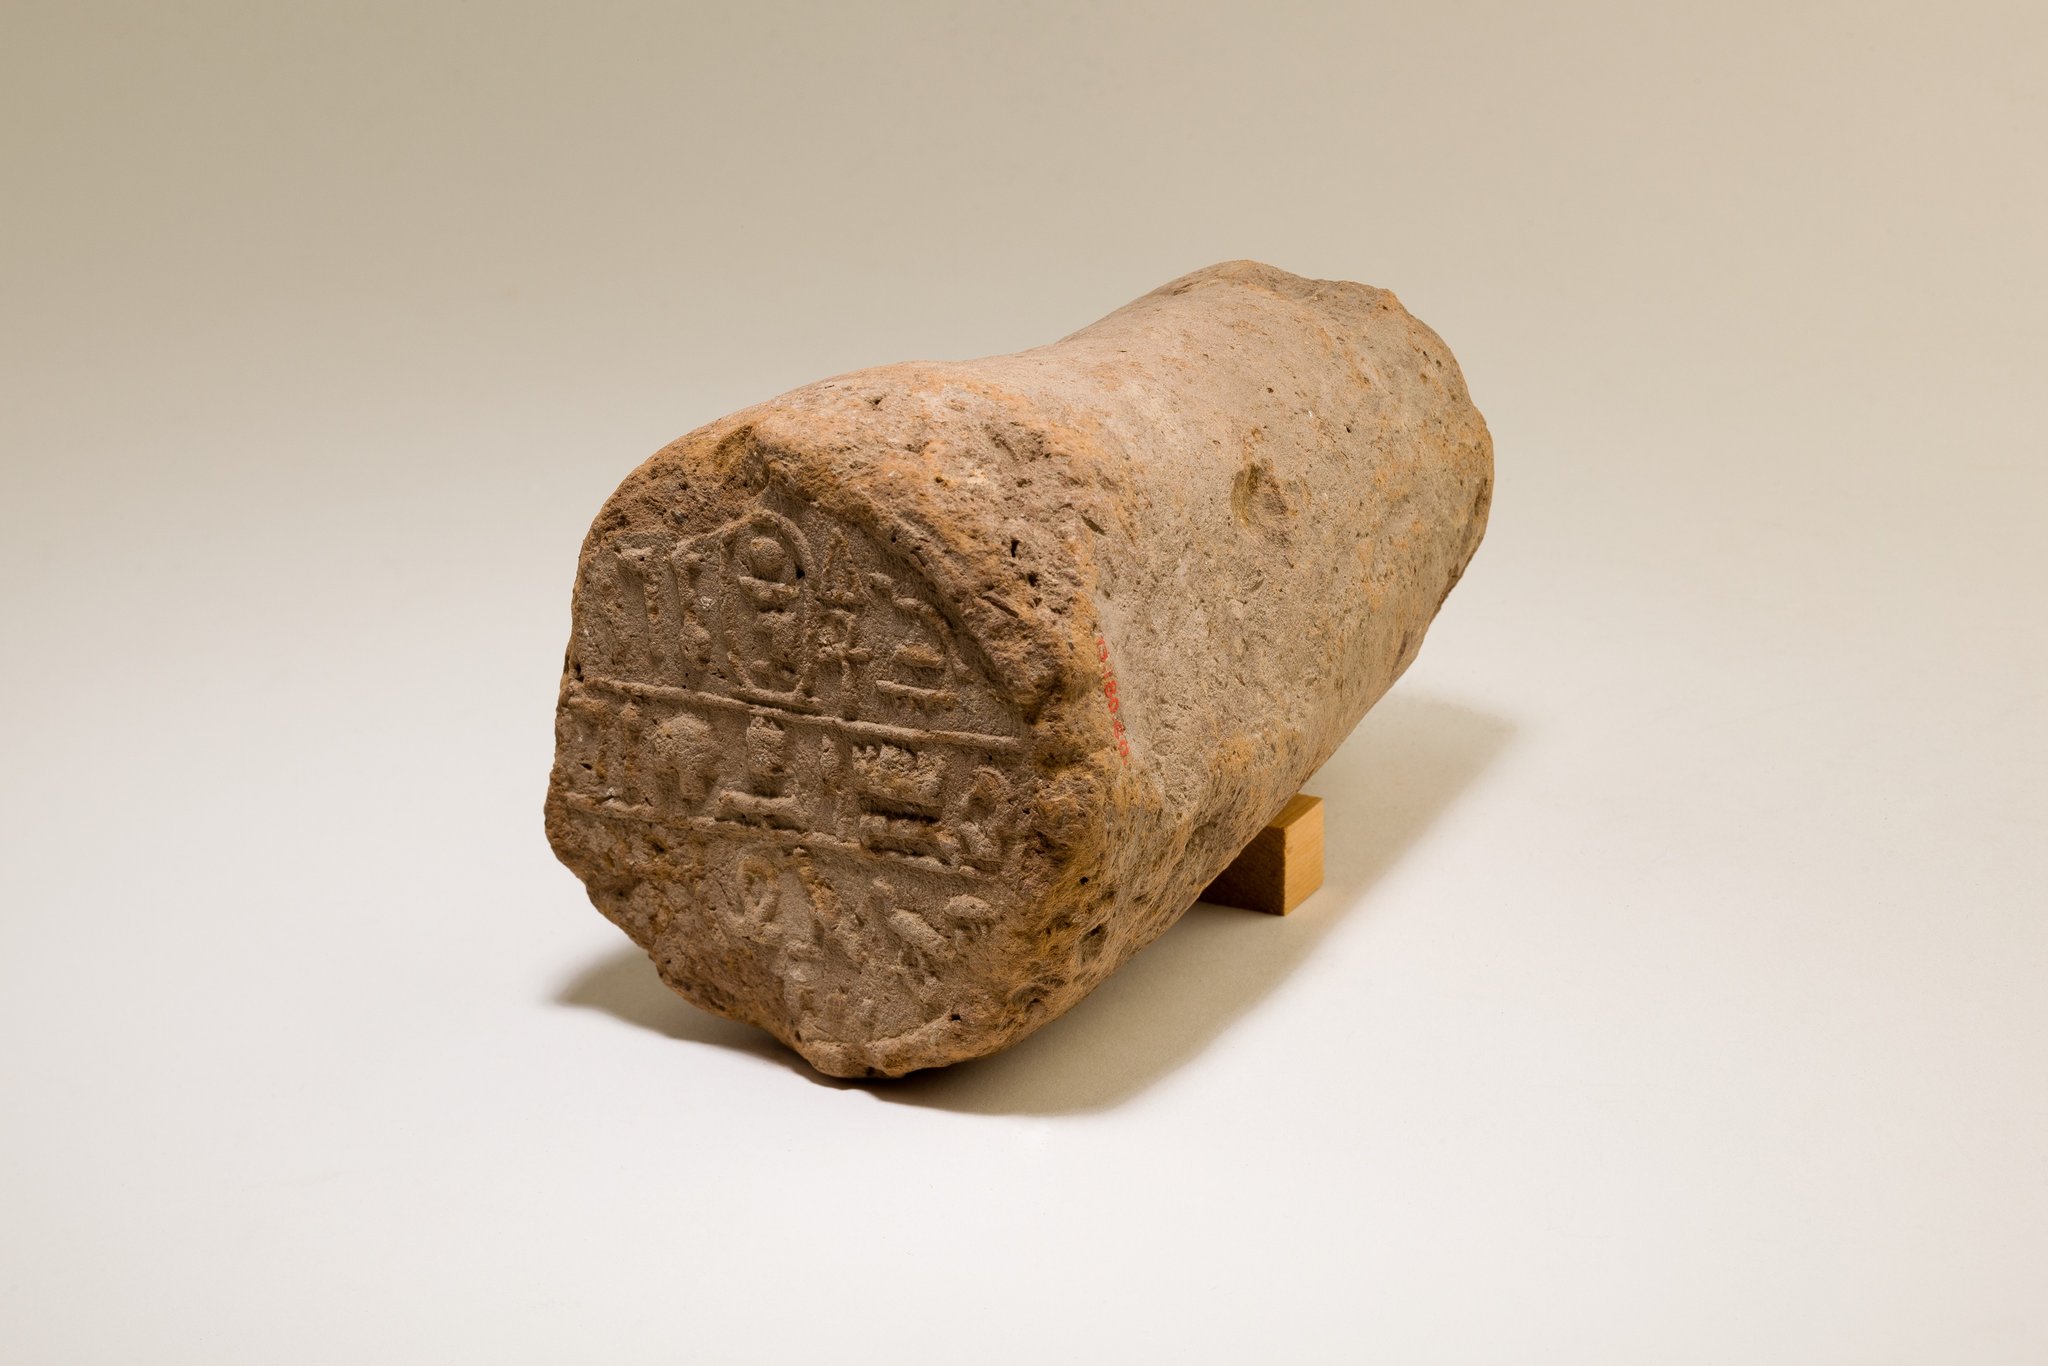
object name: cone, curcular impression, djehuty, first prophet of amun, seal bearer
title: Funerary Cone of First Prophet of Amun Djehuty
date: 1550-1525 BCE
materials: pottery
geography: egypt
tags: hieroglyphs